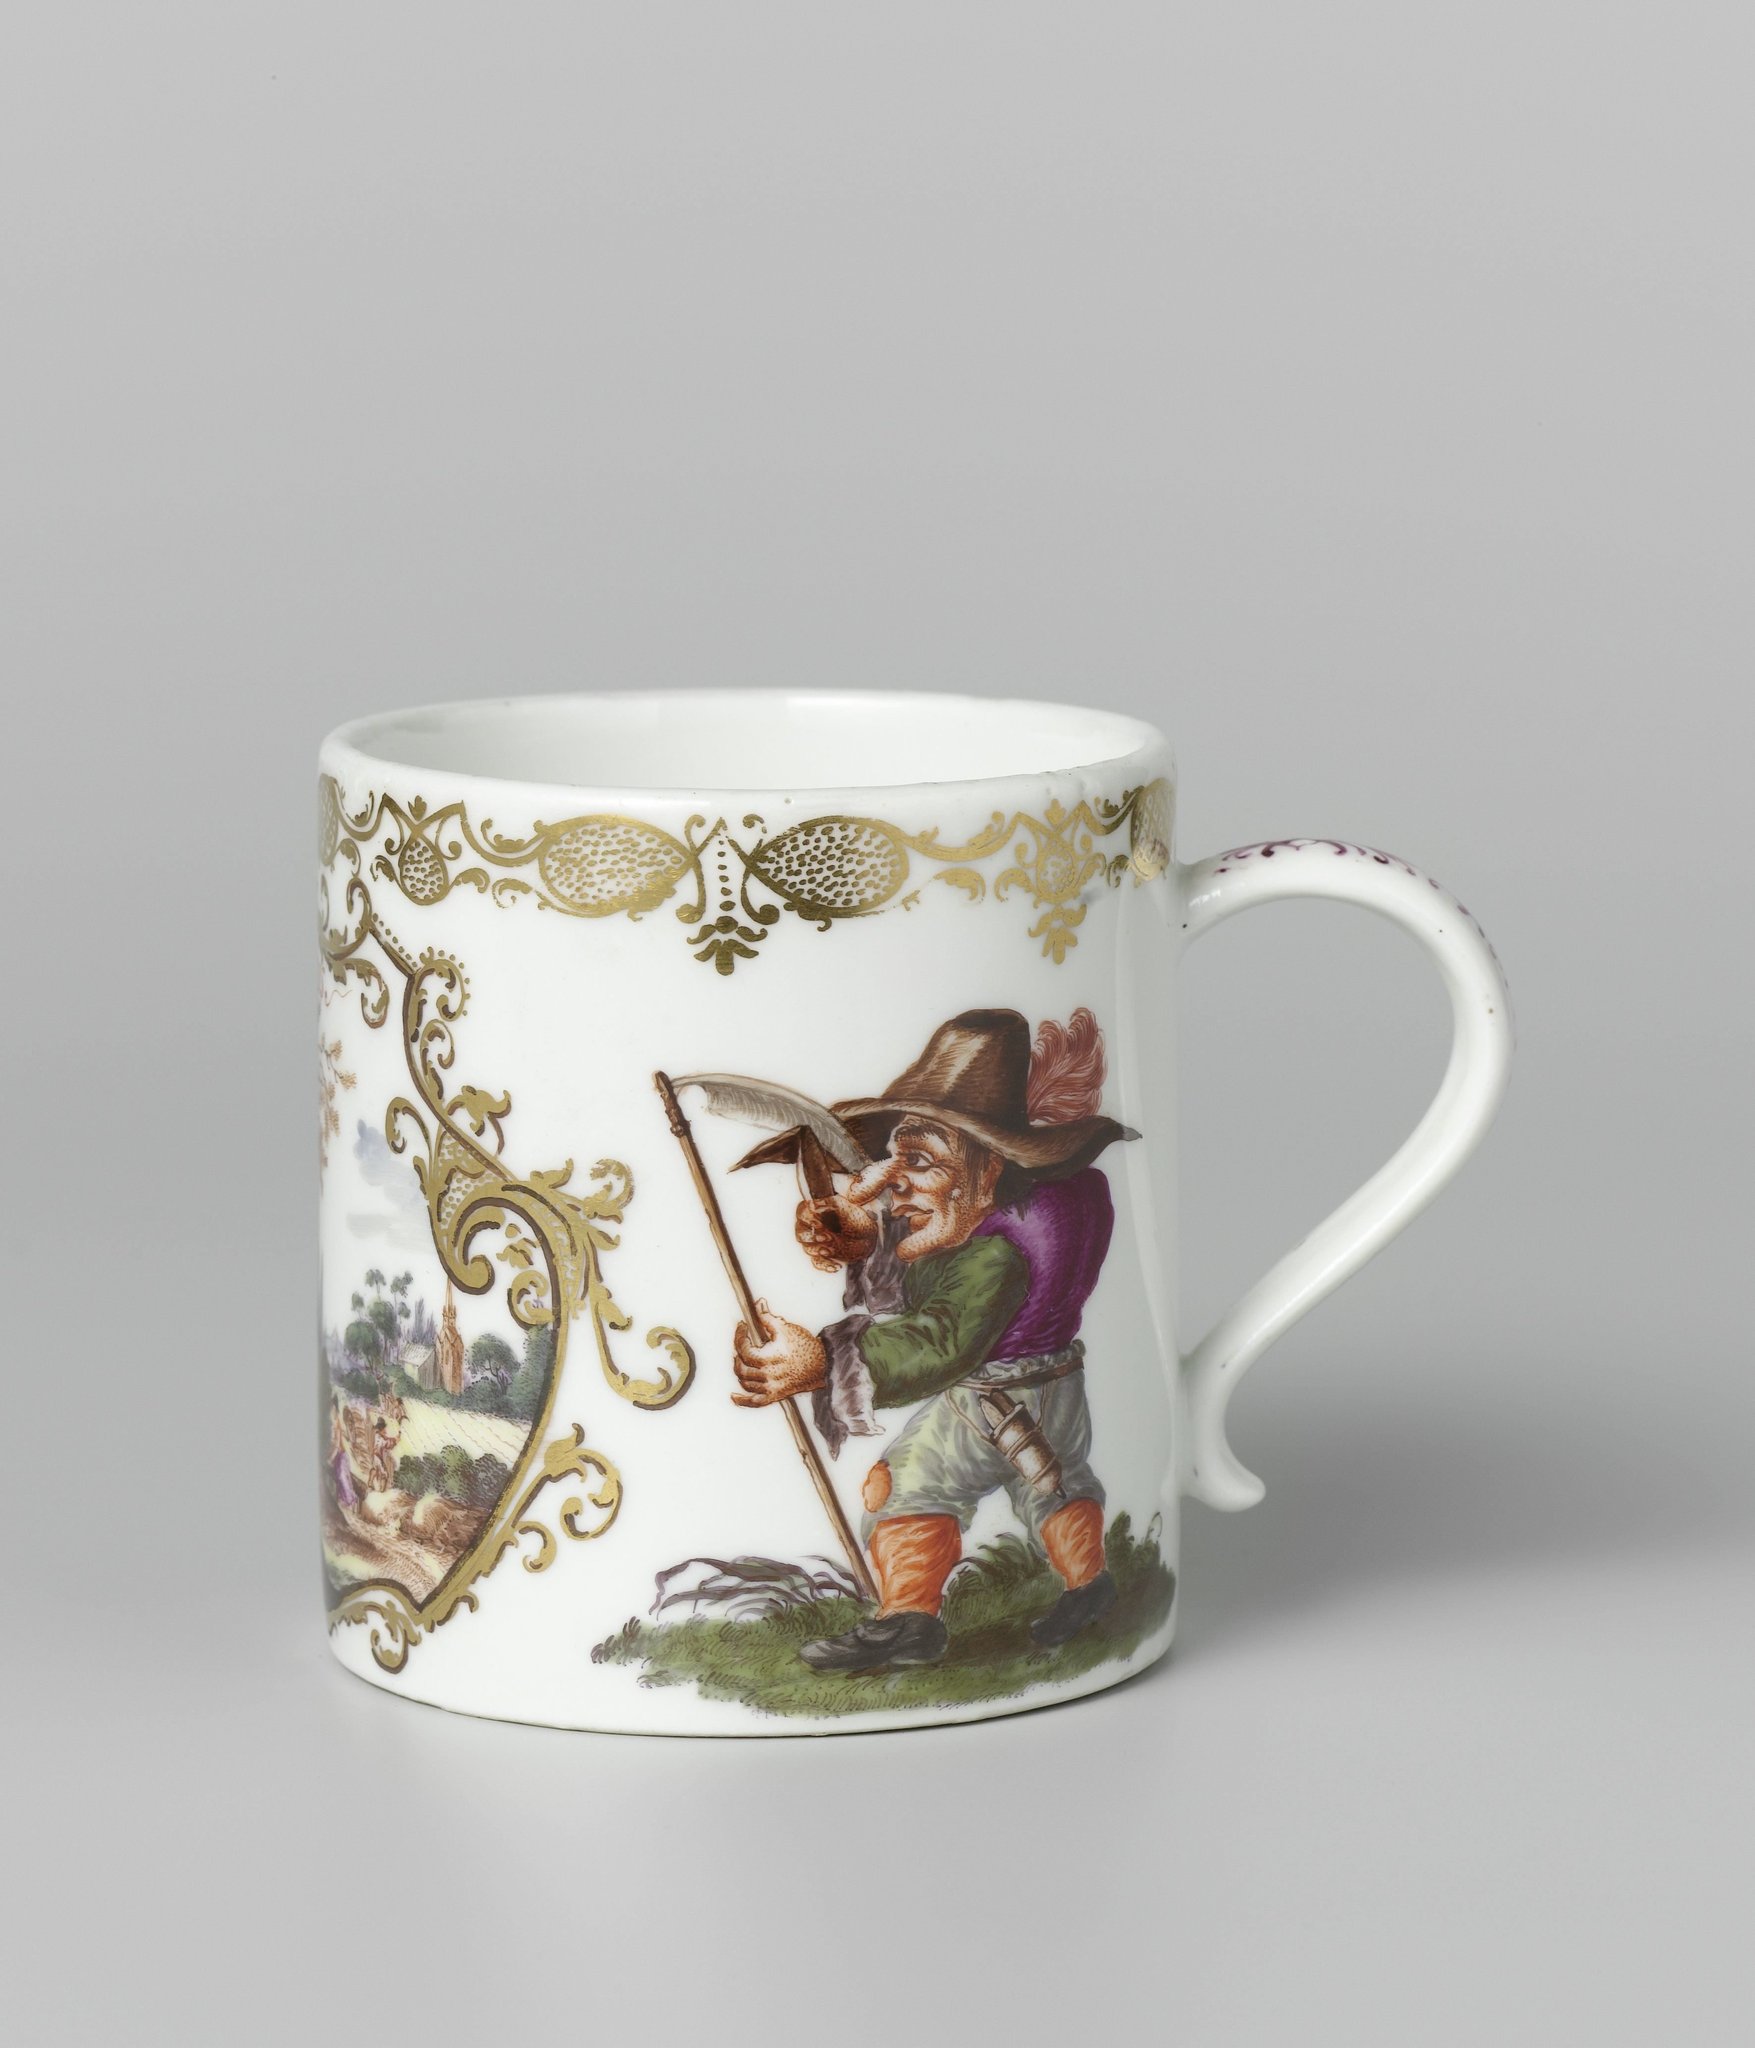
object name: cup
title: Beker met oor, veelkleurig beschilderd met een voorstelling van de maand augustus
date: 1740-1745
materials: porcelain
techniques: painted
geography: meissen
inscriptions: mark: ‘No: 1.’, factory mark, mold mark: ‘24’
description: Twelve beakers. Porcelain. Meissen, c. 1740 - 1745.